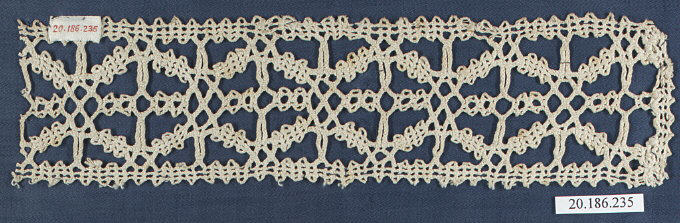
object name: insertion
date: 1501-1600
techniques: lace